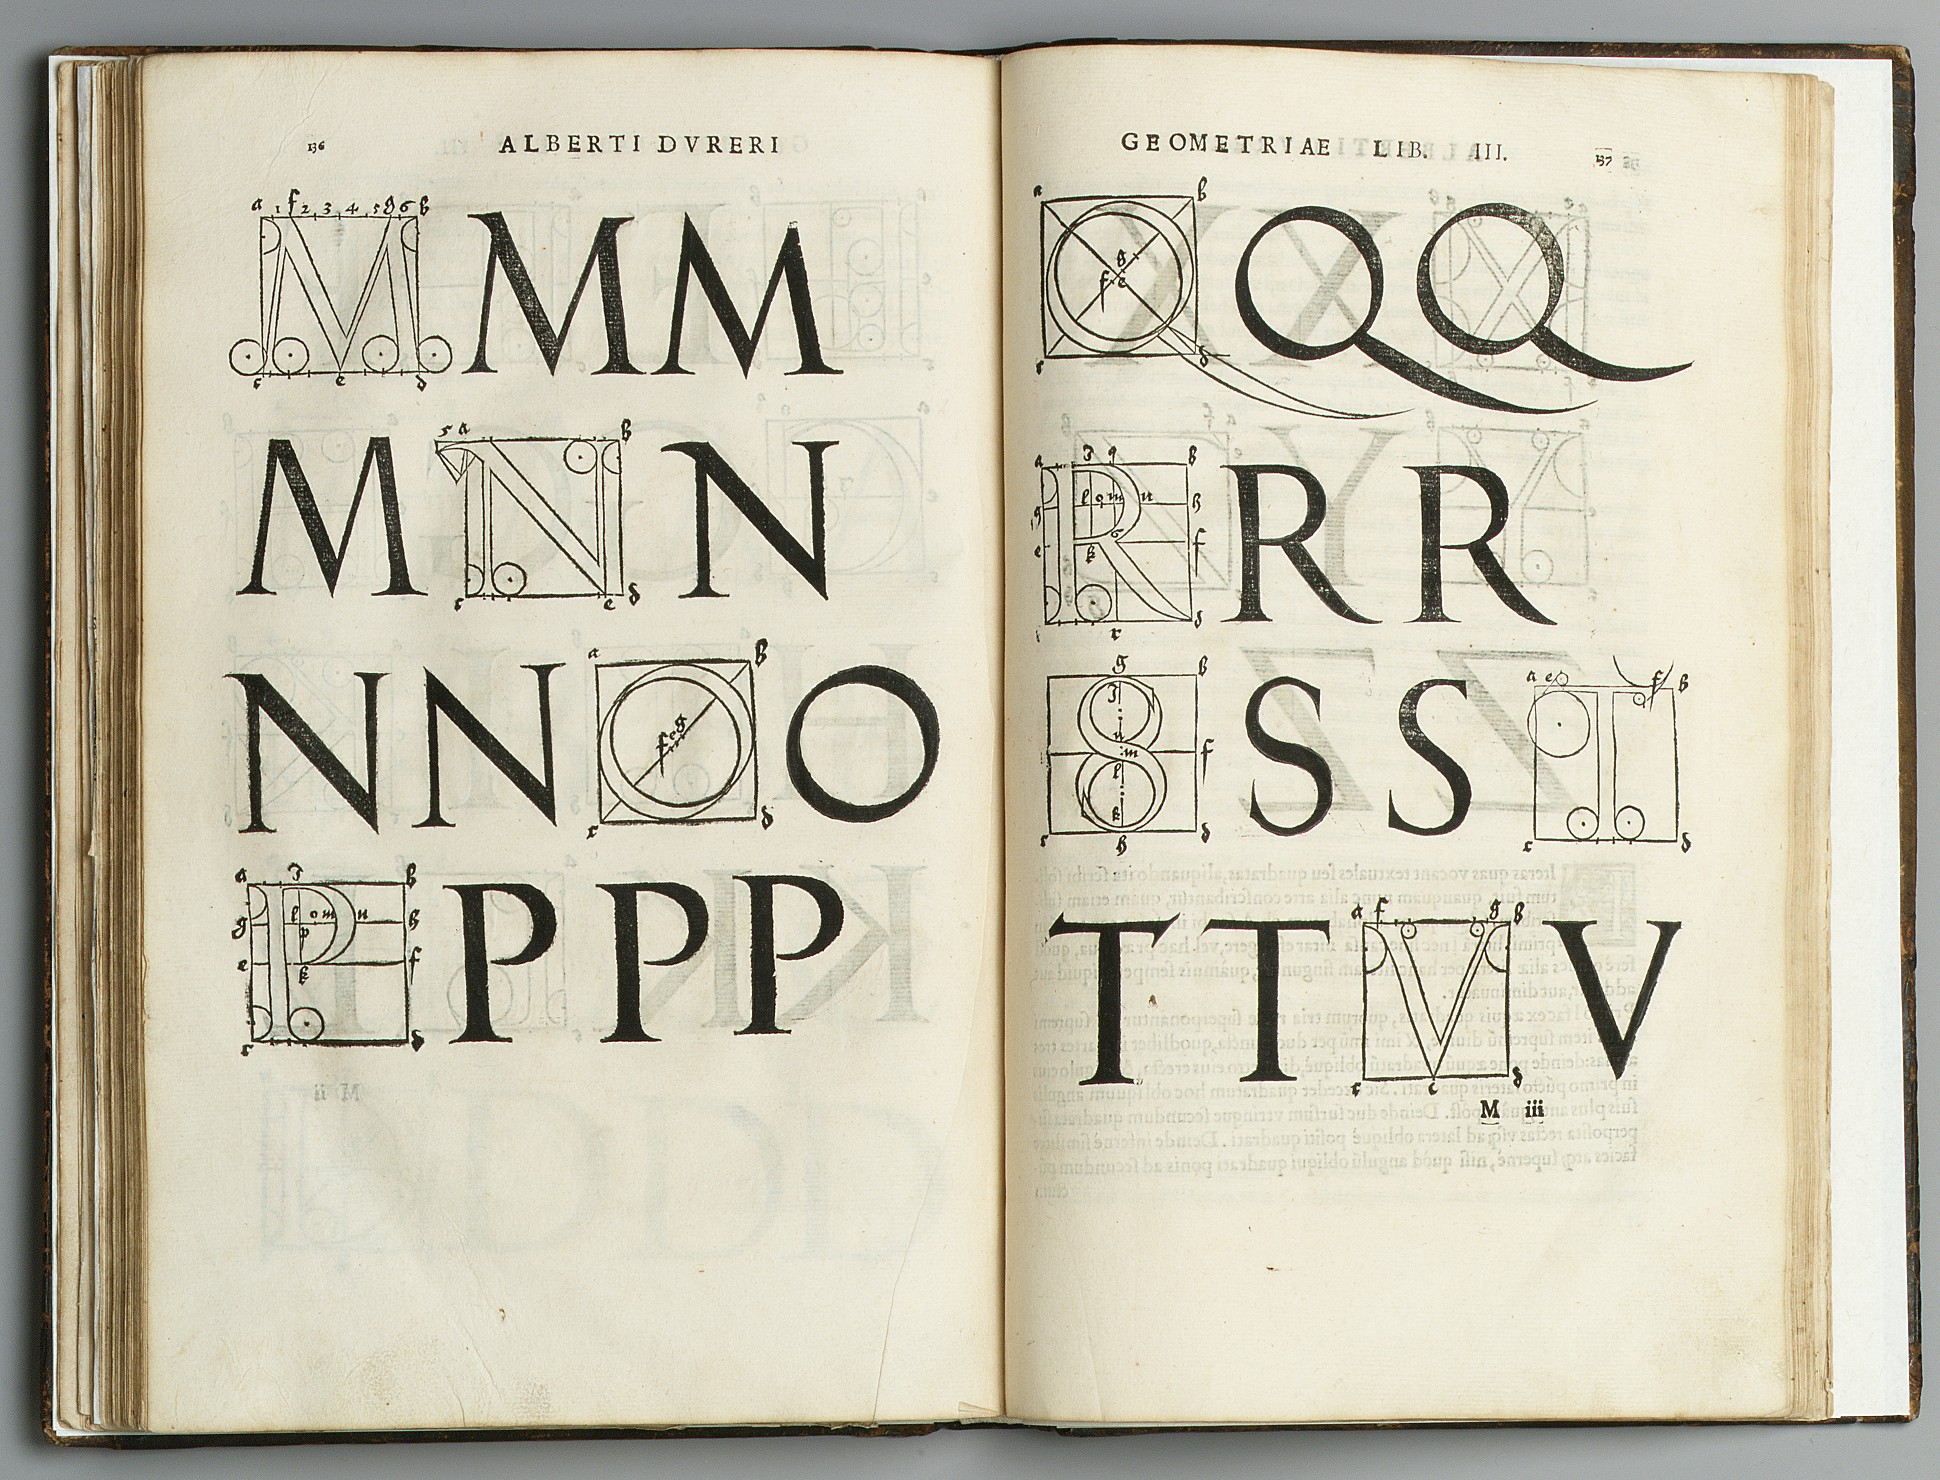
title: "Alberti Dvreri pictoris et architecti praestantissimi De vrbibvs..."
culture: french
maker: albrecht dürer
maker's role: artist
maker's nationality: german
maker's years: 1471-1528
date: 1535